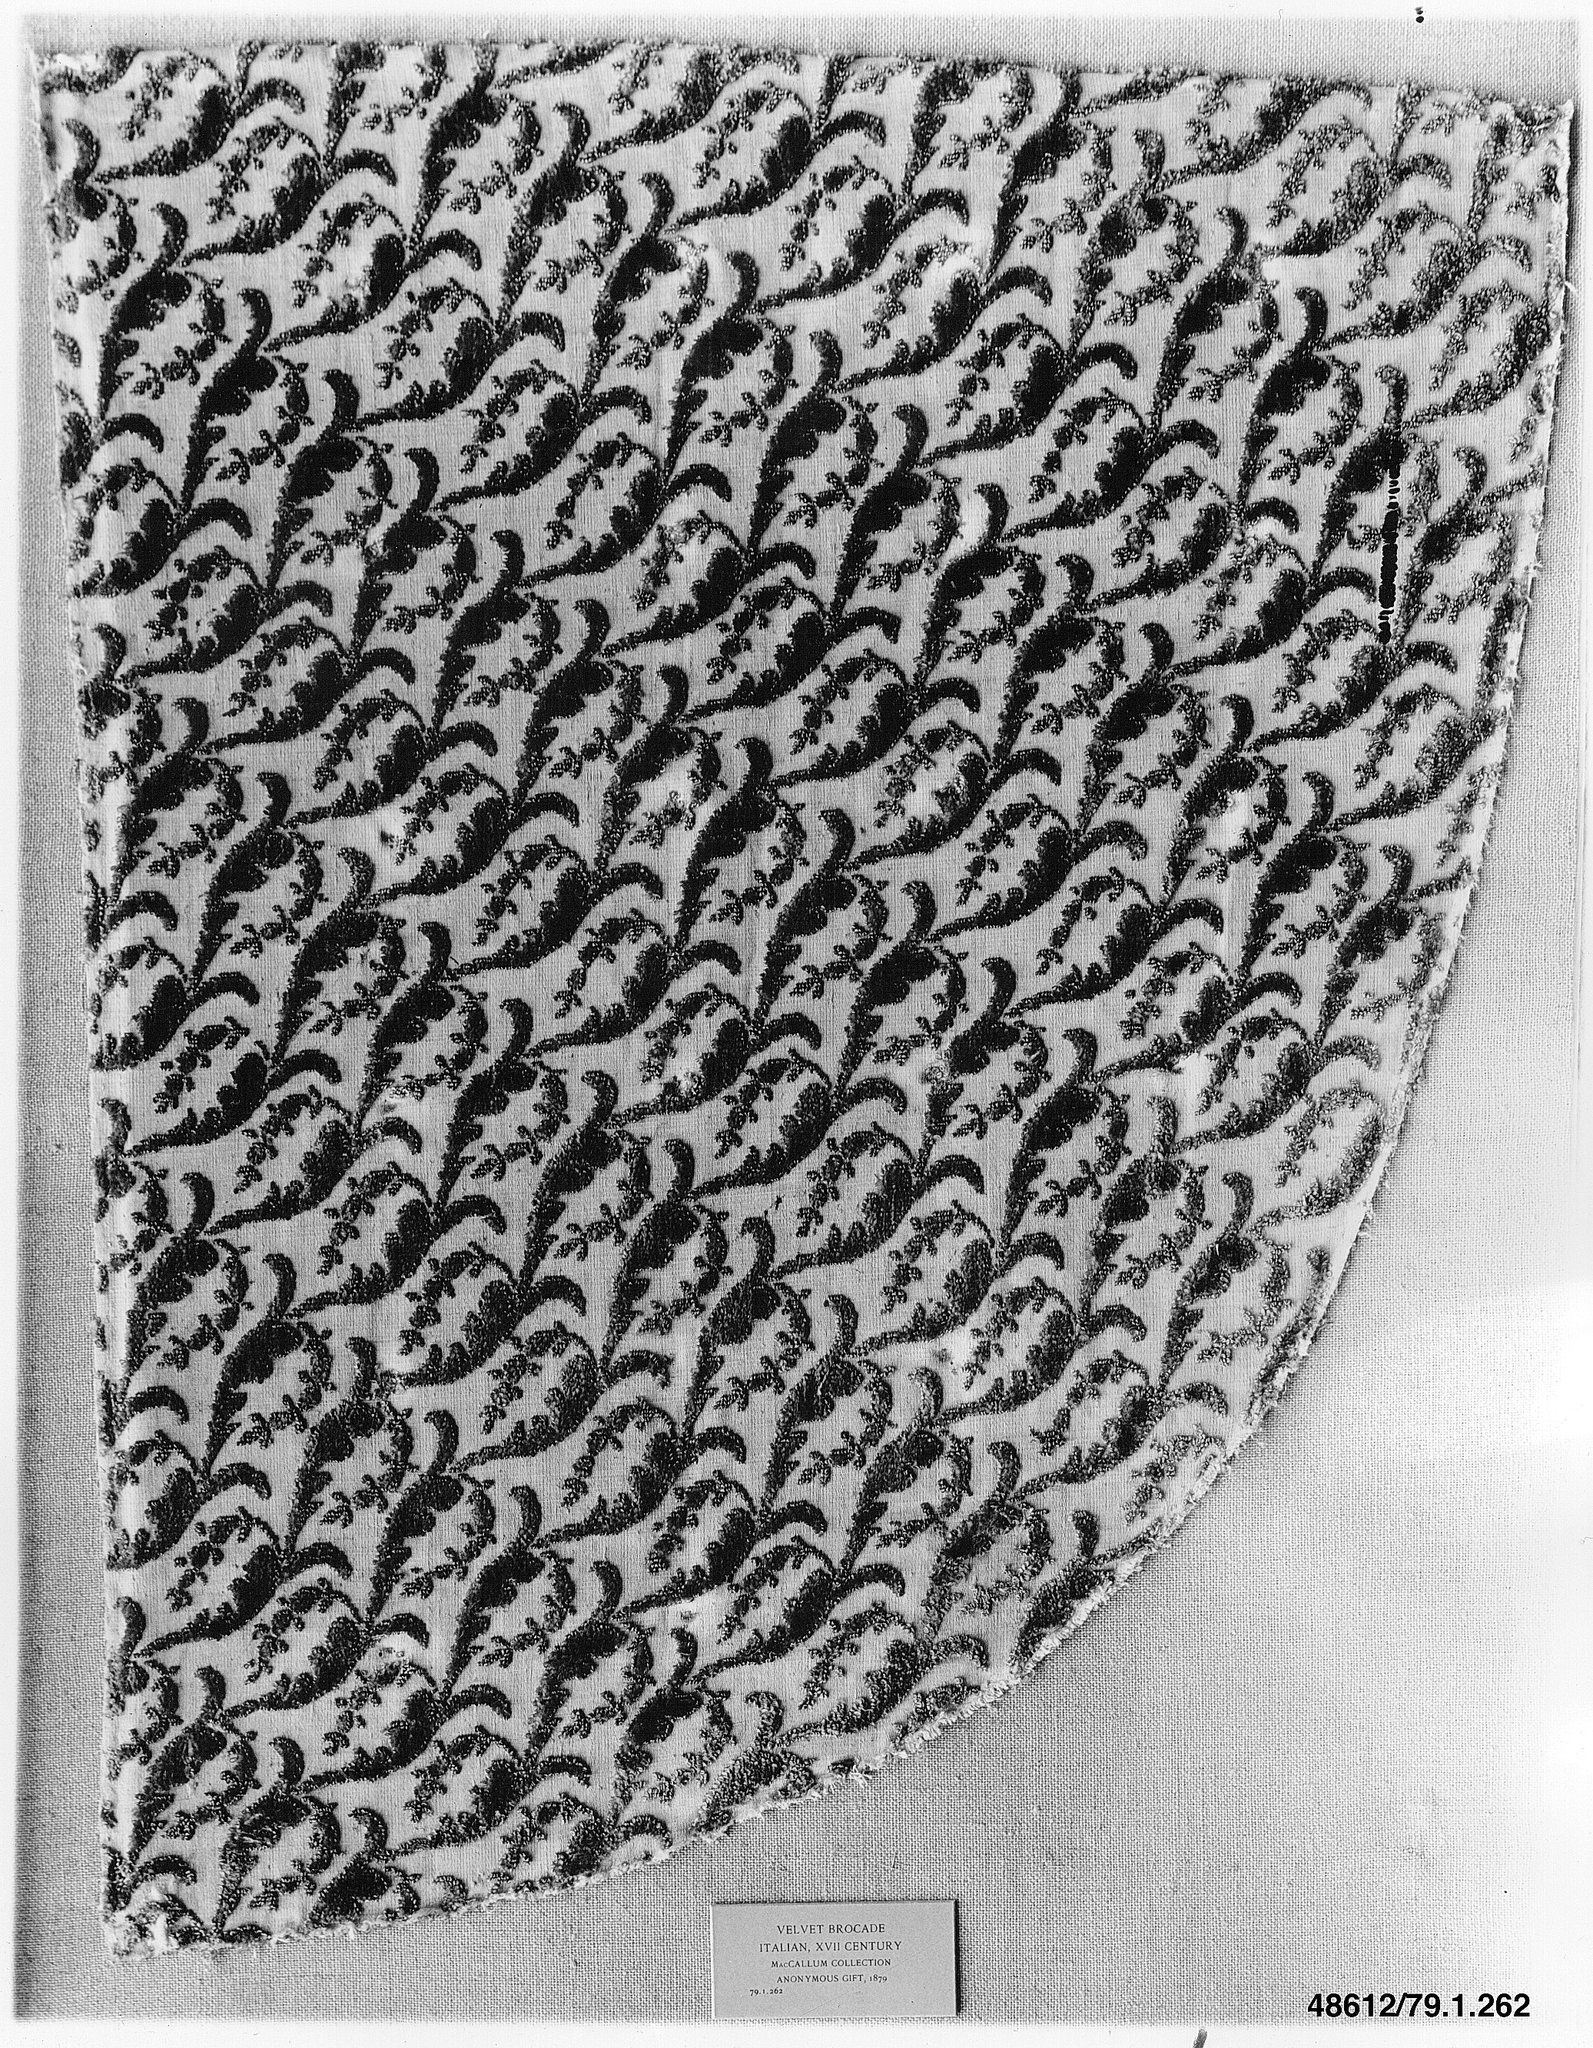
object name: piece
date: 1601-1700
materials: silk